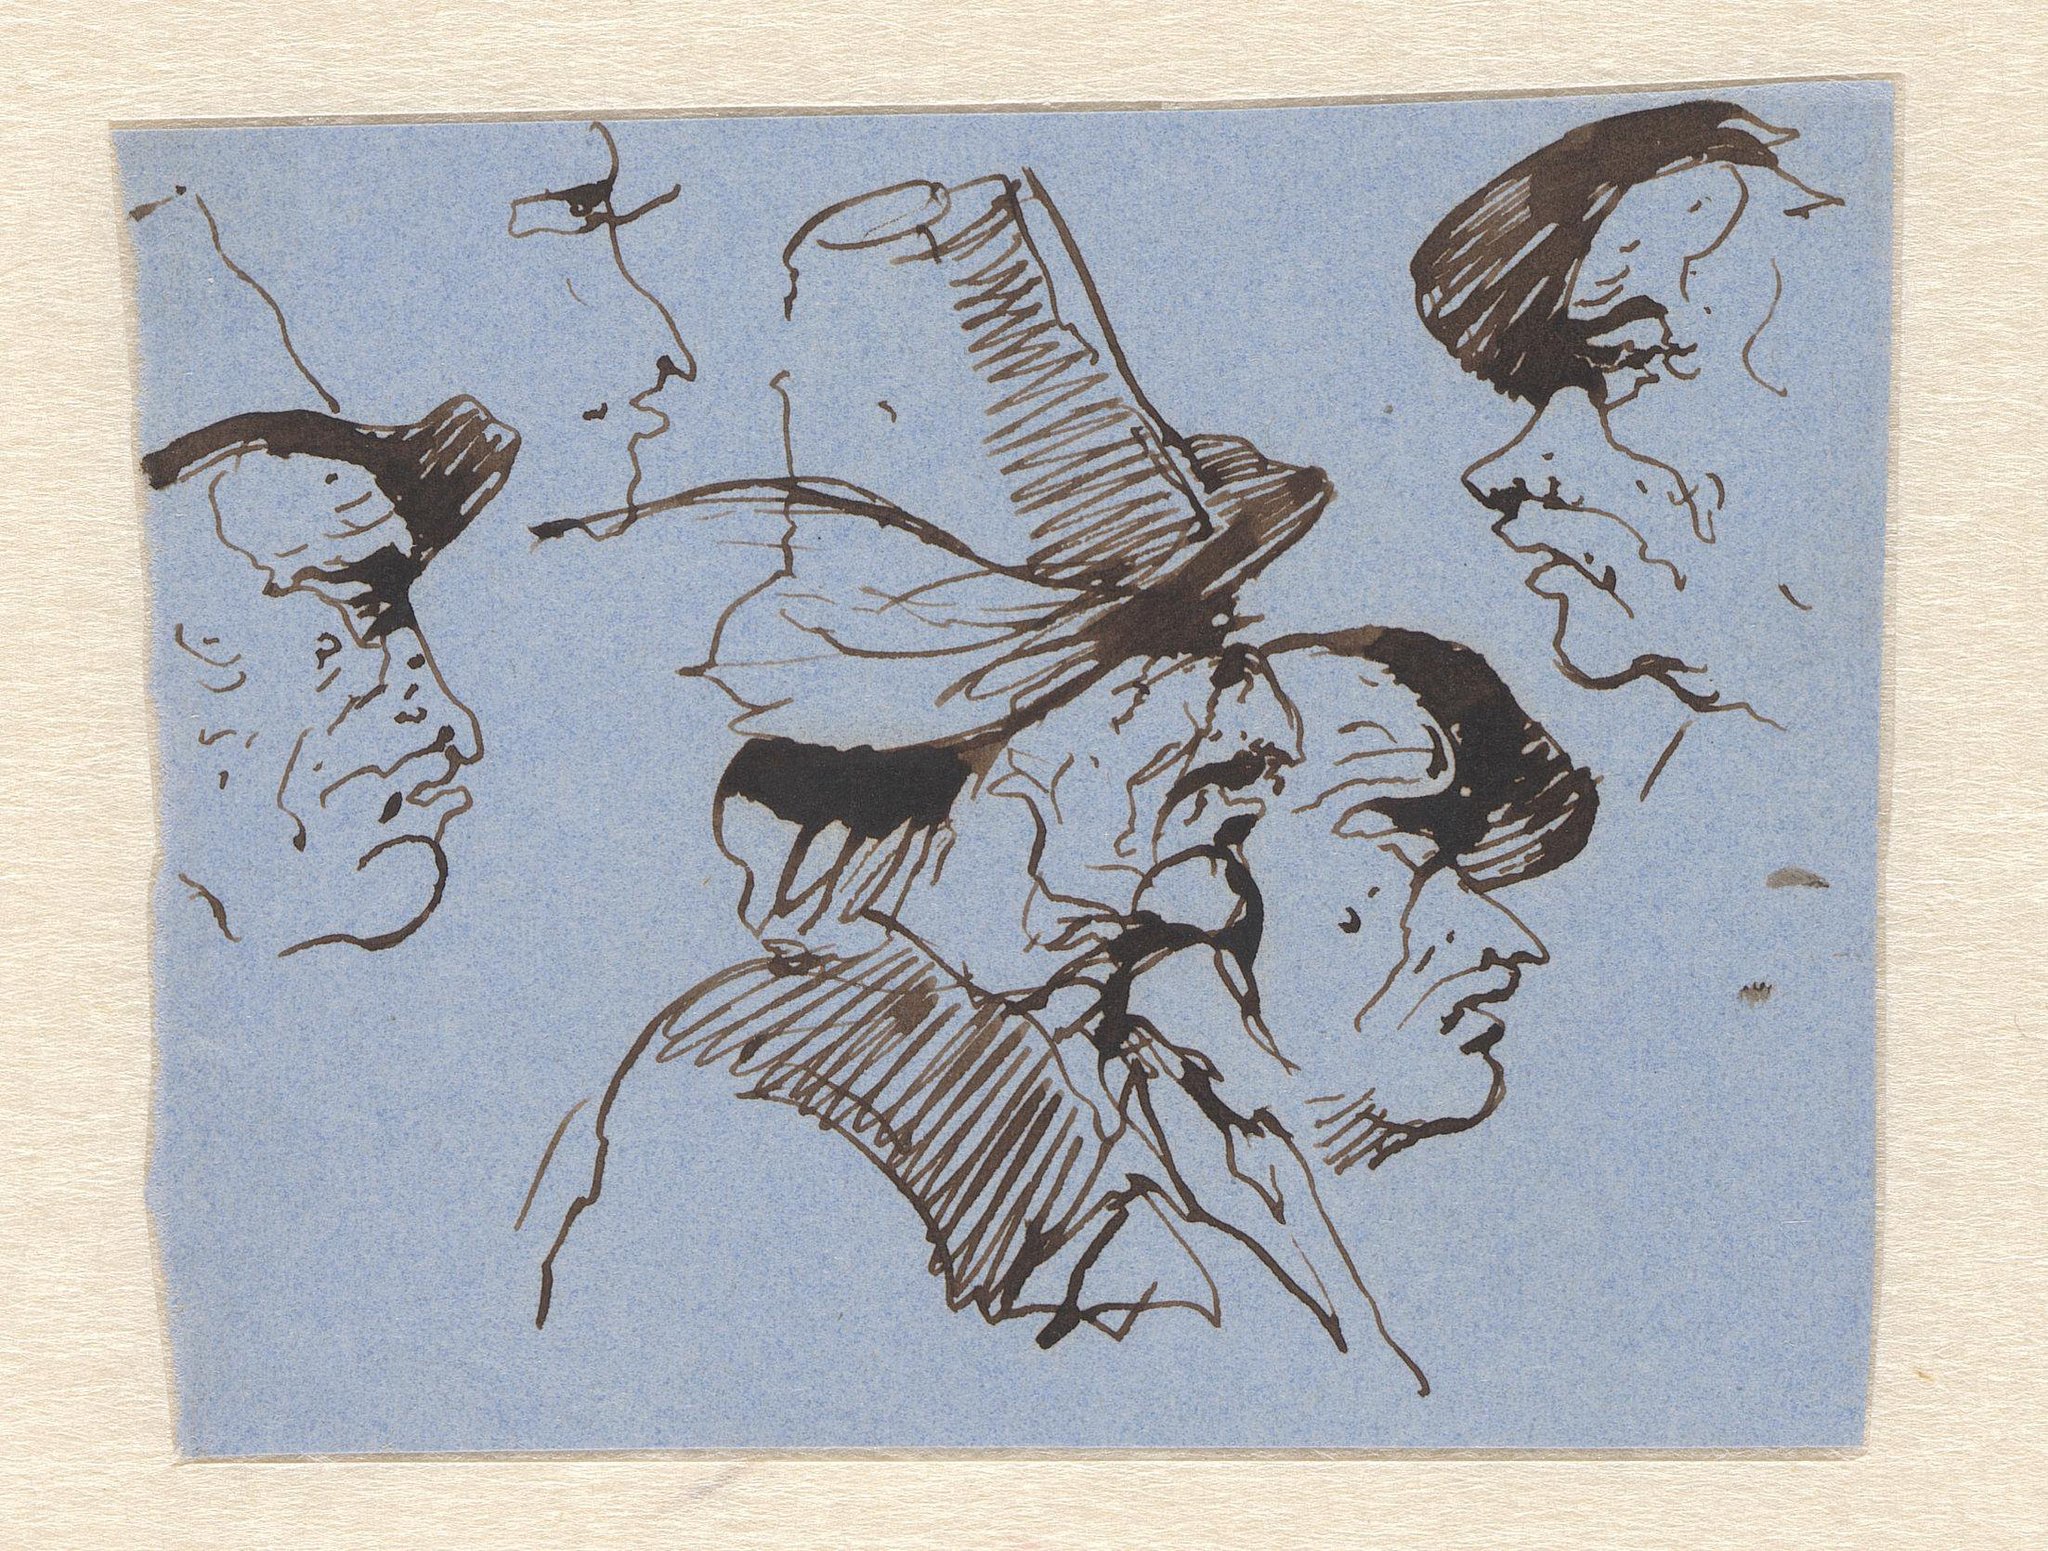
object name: drawing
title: Blad met vijf koppen en profile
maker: johannes tavenraat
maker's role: draughtsman, painter, print maker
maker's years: 1809-1881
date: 1840-1880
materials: ink, paper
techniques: pen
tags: caricatures (human types)